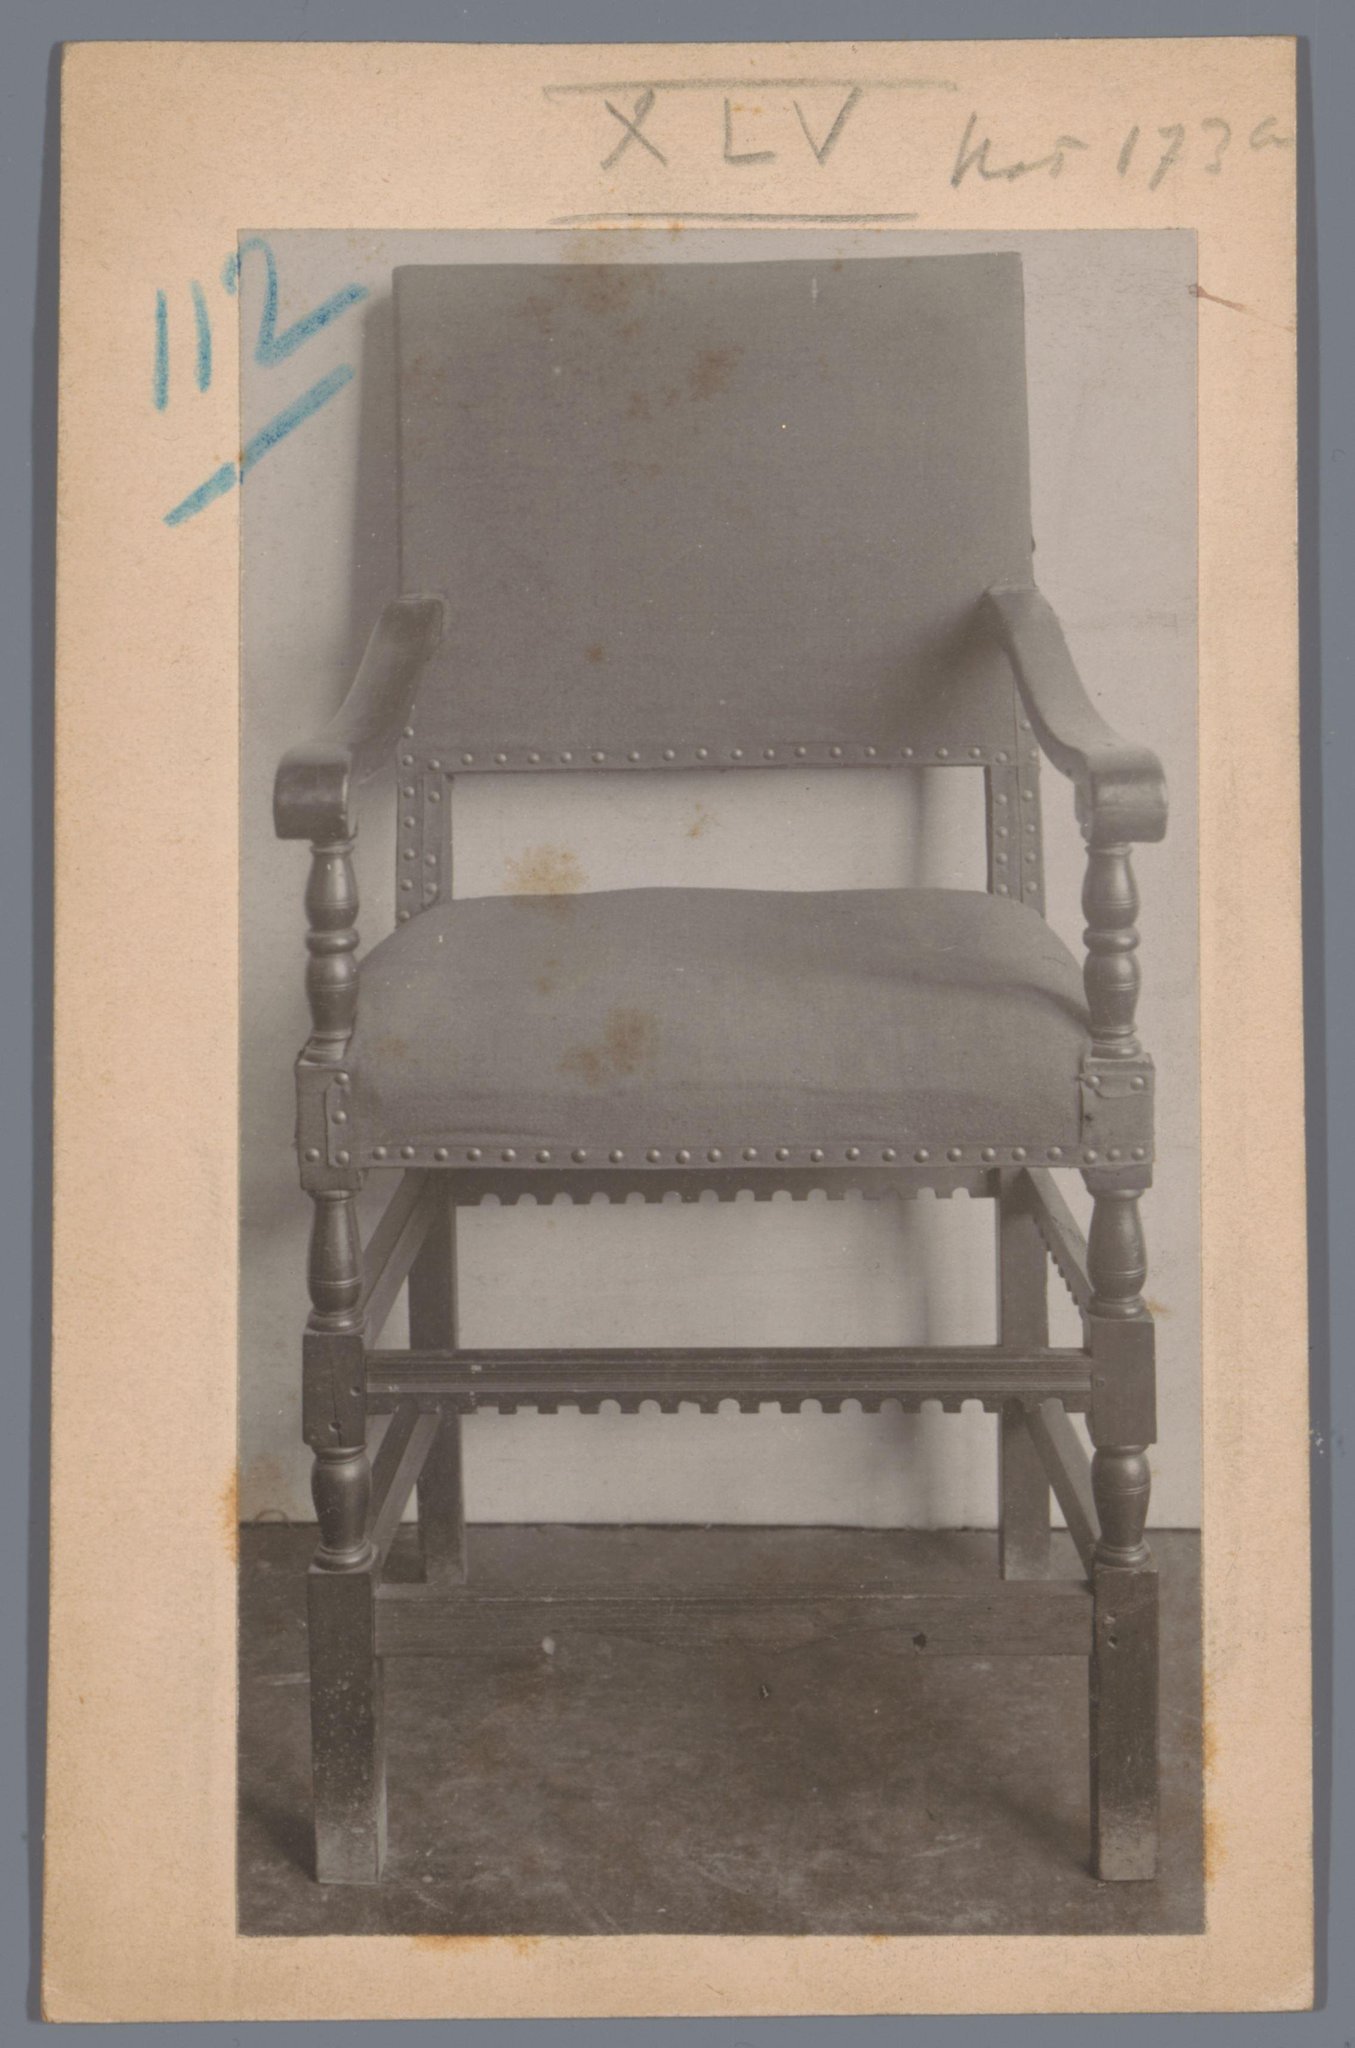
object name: photograph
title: Armstoel in het Rijksmuseum te Amsterdam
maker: Anonymous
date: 1875-1900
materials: photographic support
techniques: matte daylight collodion silver print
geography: amsterdam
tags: chair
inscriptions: number: ‘XLV kat 173a 112’, collector's mark: ‘Instituut voor kunst-nijverheidsonderwijs Gabriël Metsustraat No. 16, Amsterdam’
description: Zie voor het originele object BK-KOG-601 of BK-KOG-602.